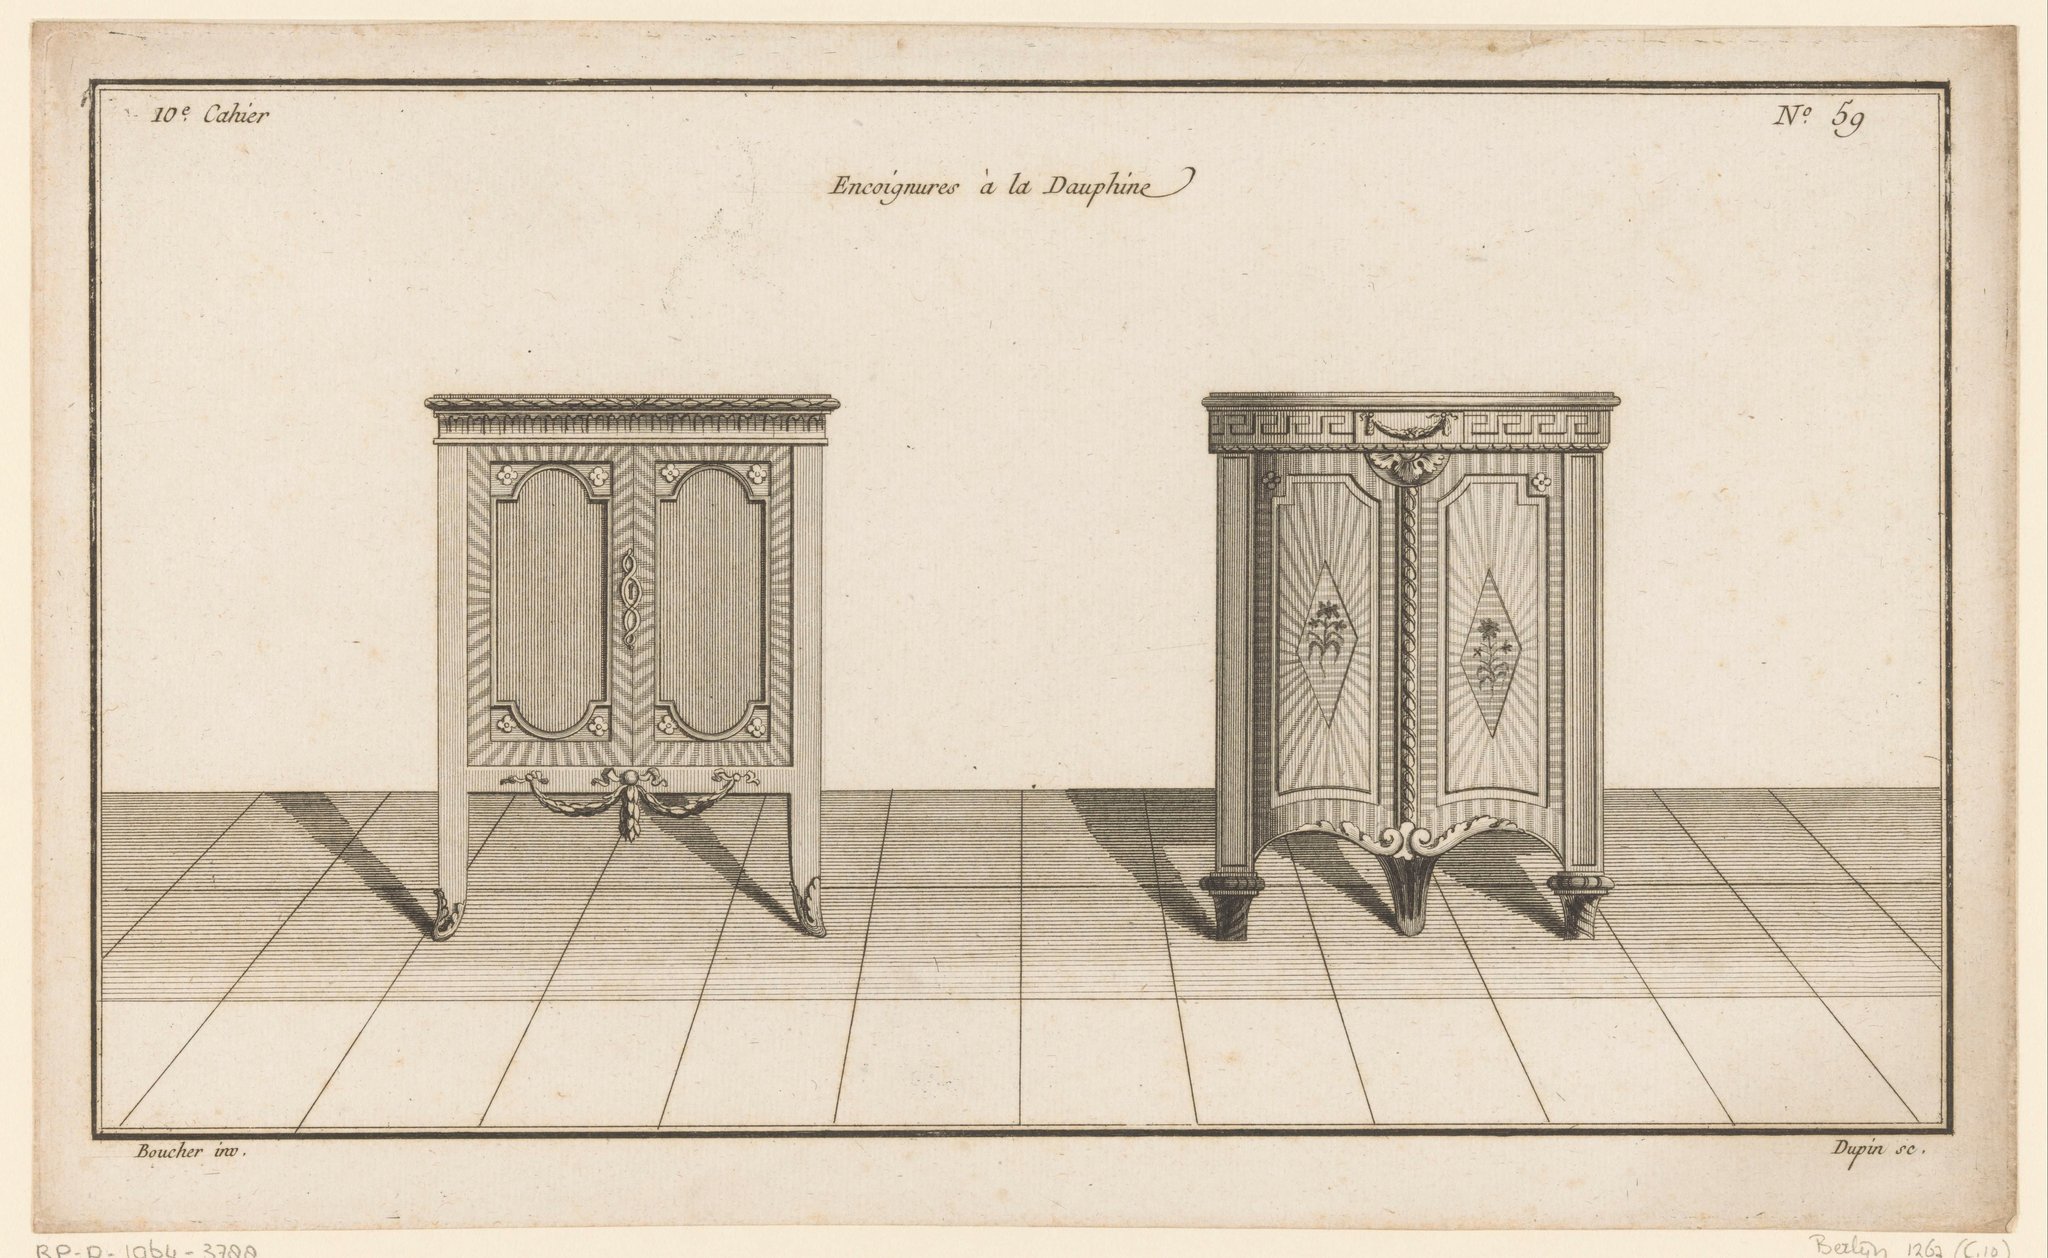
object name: ornament print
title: Secretaires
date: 1772-1779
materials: paper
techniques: engraving, etching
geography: paris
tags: ornamental cupboard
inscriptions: collector's mark: Lugt 2228, collector's mark: Lugt 2760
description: Twee geornamenteerde hoekkasten, rechts met bloemmotieven. Prentnummer 59.